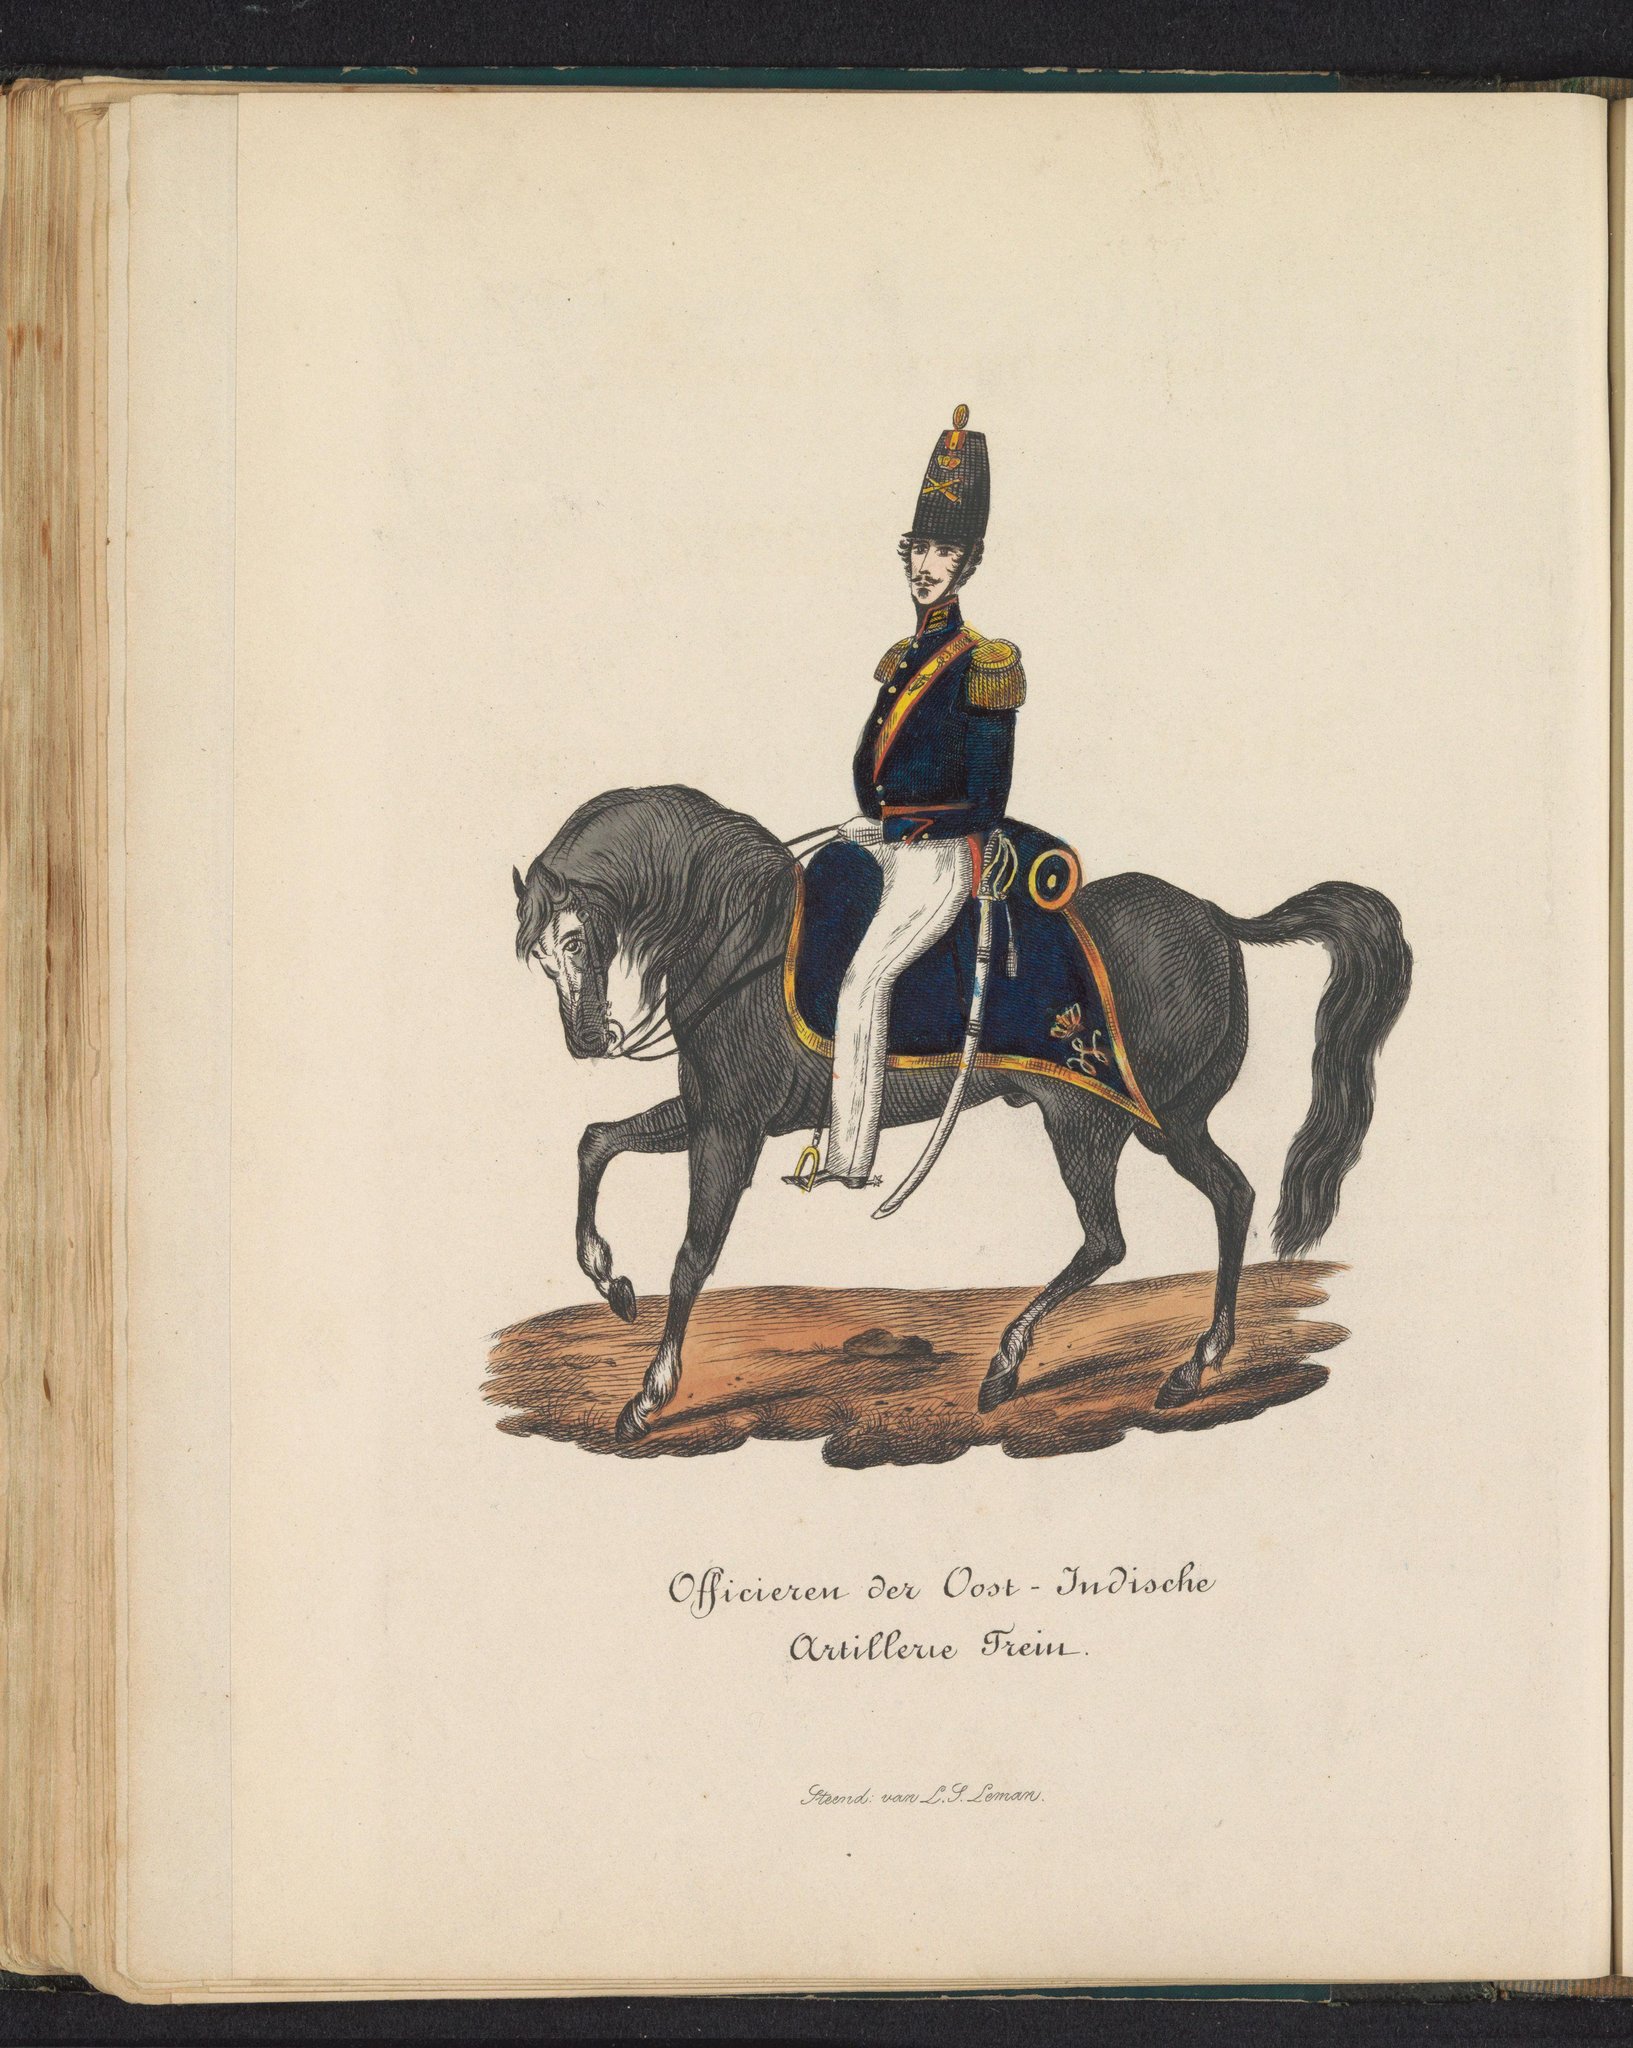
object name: book illustration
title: Uniform van de officieren van de artillerie transporttrein van de Oost-Indische troepen, 1845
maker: louis salomon leman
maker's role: steendrukker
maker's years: 1818-1889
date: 1845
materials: paper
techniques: hand coloring, lithograph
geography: netherlands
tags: (military) uniforms, netherlands, dutch east indies, the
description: Uniform van de officieren van de artillerie transporttrein van de Oost-Indische troepen. Illustratie in een boek uit 1845 over de uniformen en kledingstukken van de Nederlandse land-, zeemacht en schutterijen in Nederland en in de overzeese gebiedsdelen.